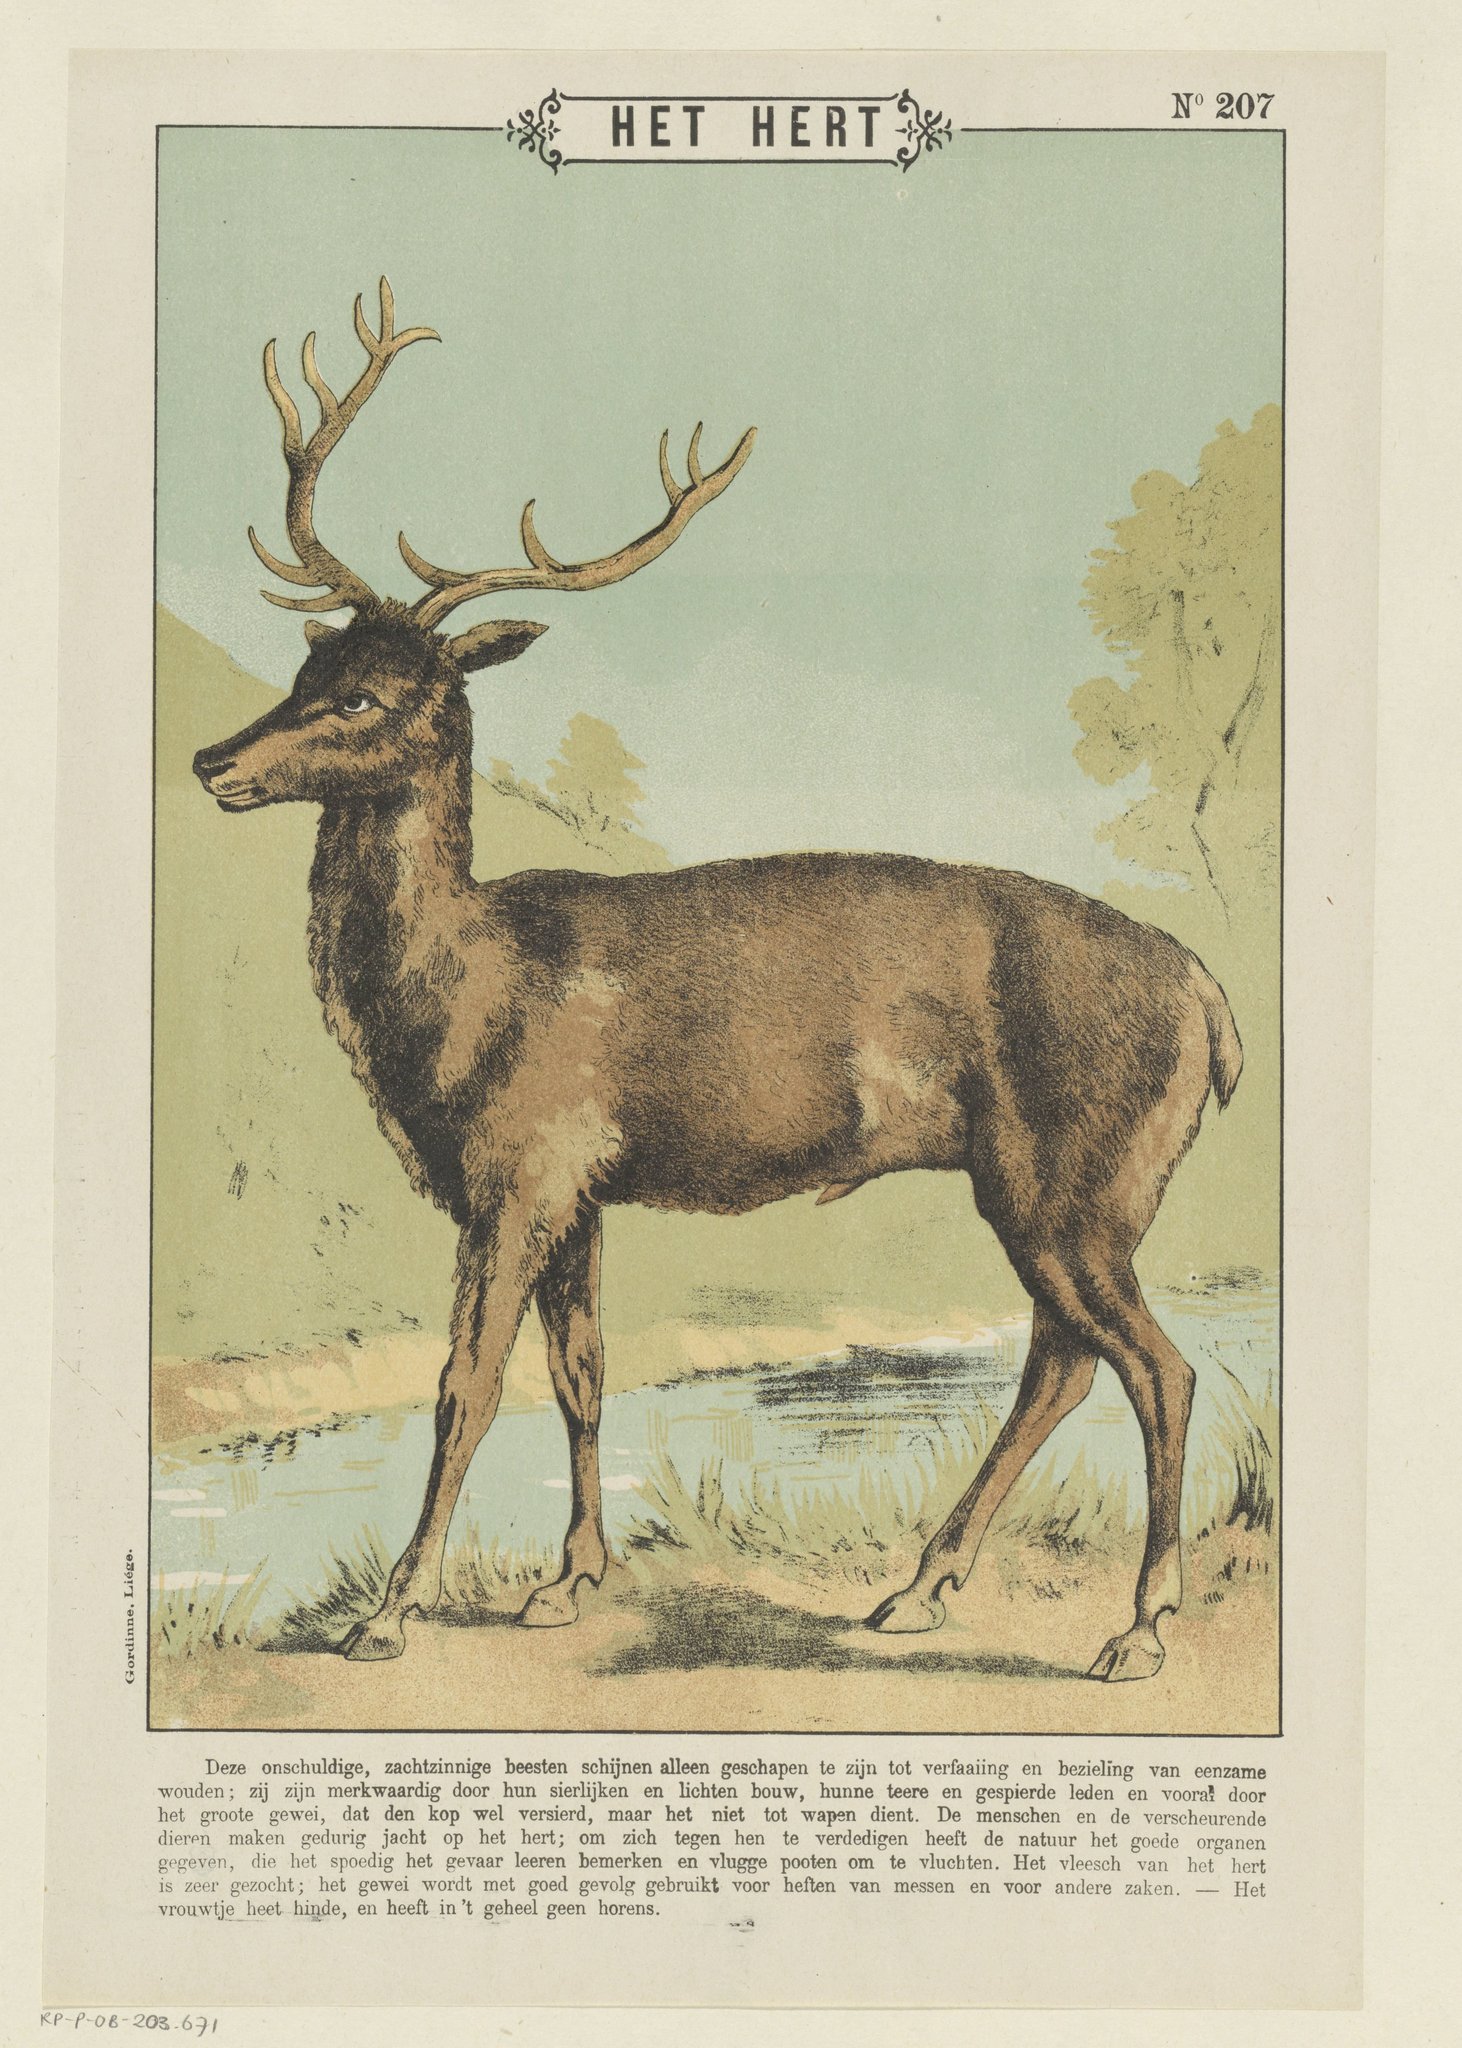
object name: popular print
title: Het hert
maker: Anonymous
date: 1894-1959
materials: paper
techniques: lithograph, letterpress printing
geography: liège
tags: hoofed animals: deer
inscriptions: collector's mark: Lugt 2760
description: Blad met een grote voorstelling van een hert. In de ondermarge een onderschrift. Genummerd rechtsboven: No 207.